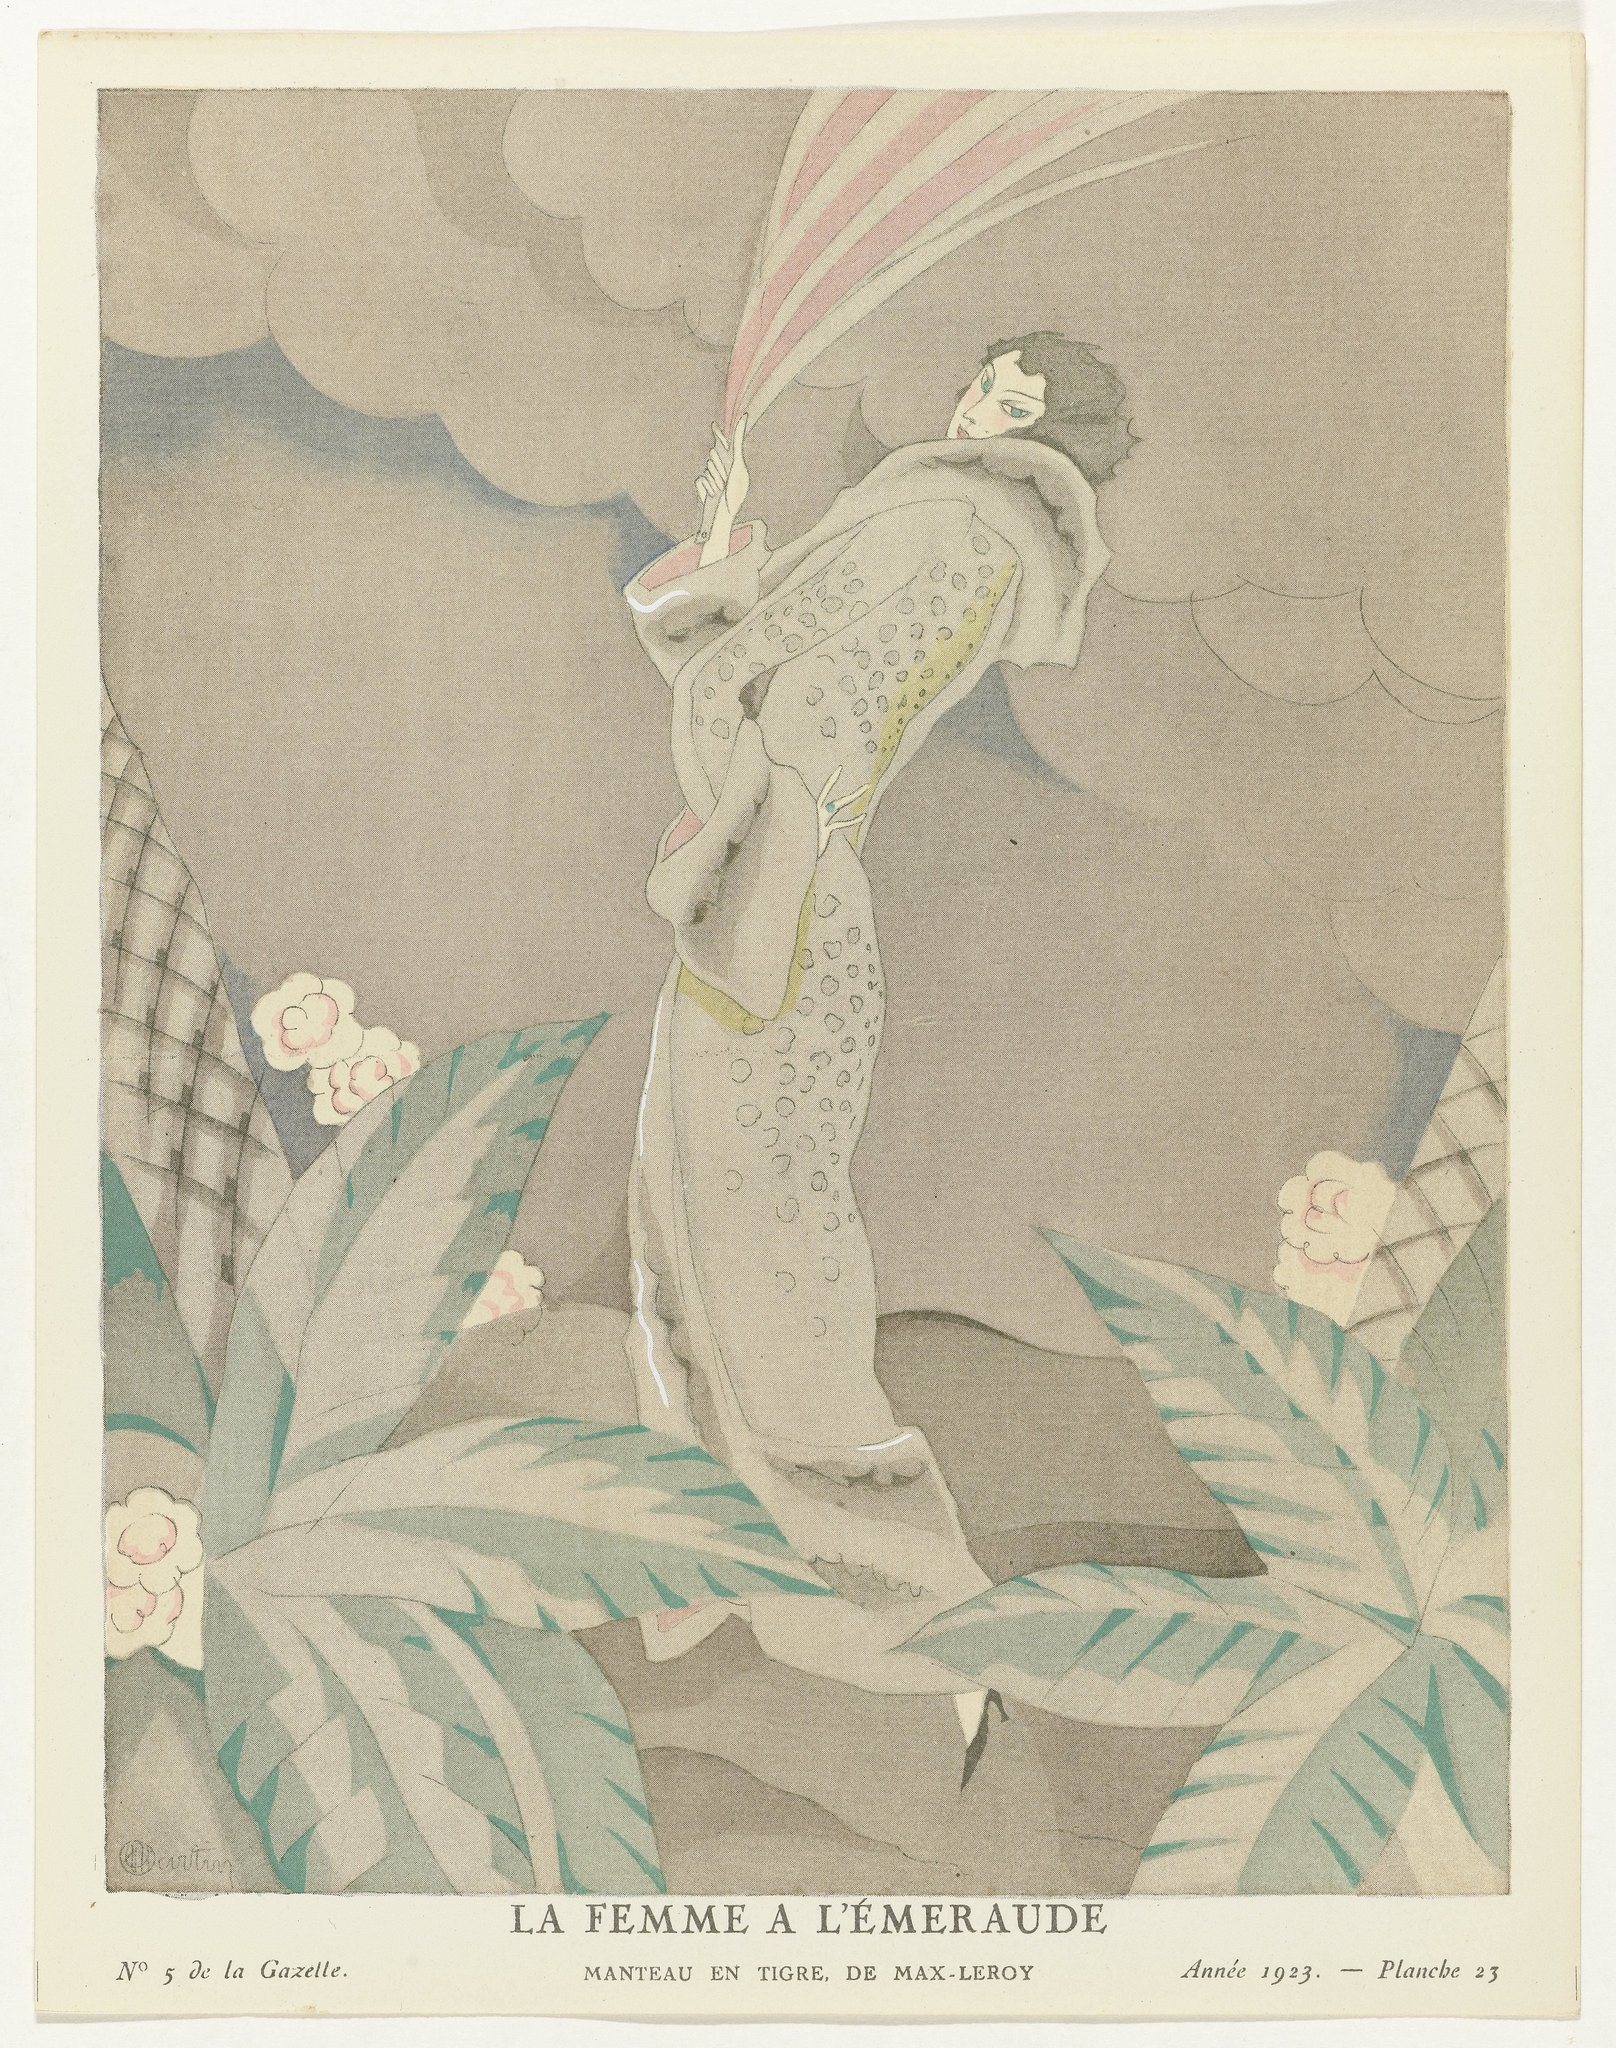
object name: fashion print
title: Gazette du Bon Ton 1923, No. 5, Pl. 23: La Femme a l'Émeraude - Manteau en tigre, de Max-Leroy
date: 1923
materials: paper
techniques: printing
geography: paris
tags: coat (+ fur used for clothes), coat (+ women's clothes), fashion plates, clothes, costume (+ women's clothes)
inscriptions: date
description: De titel is volgens Museum of Fine Arts in Boston 'La Femme a l'Émeraude - Manteau en tigre, de Max-Leroy, plate 23 from Gazette du Bon Ton, No. 5'.